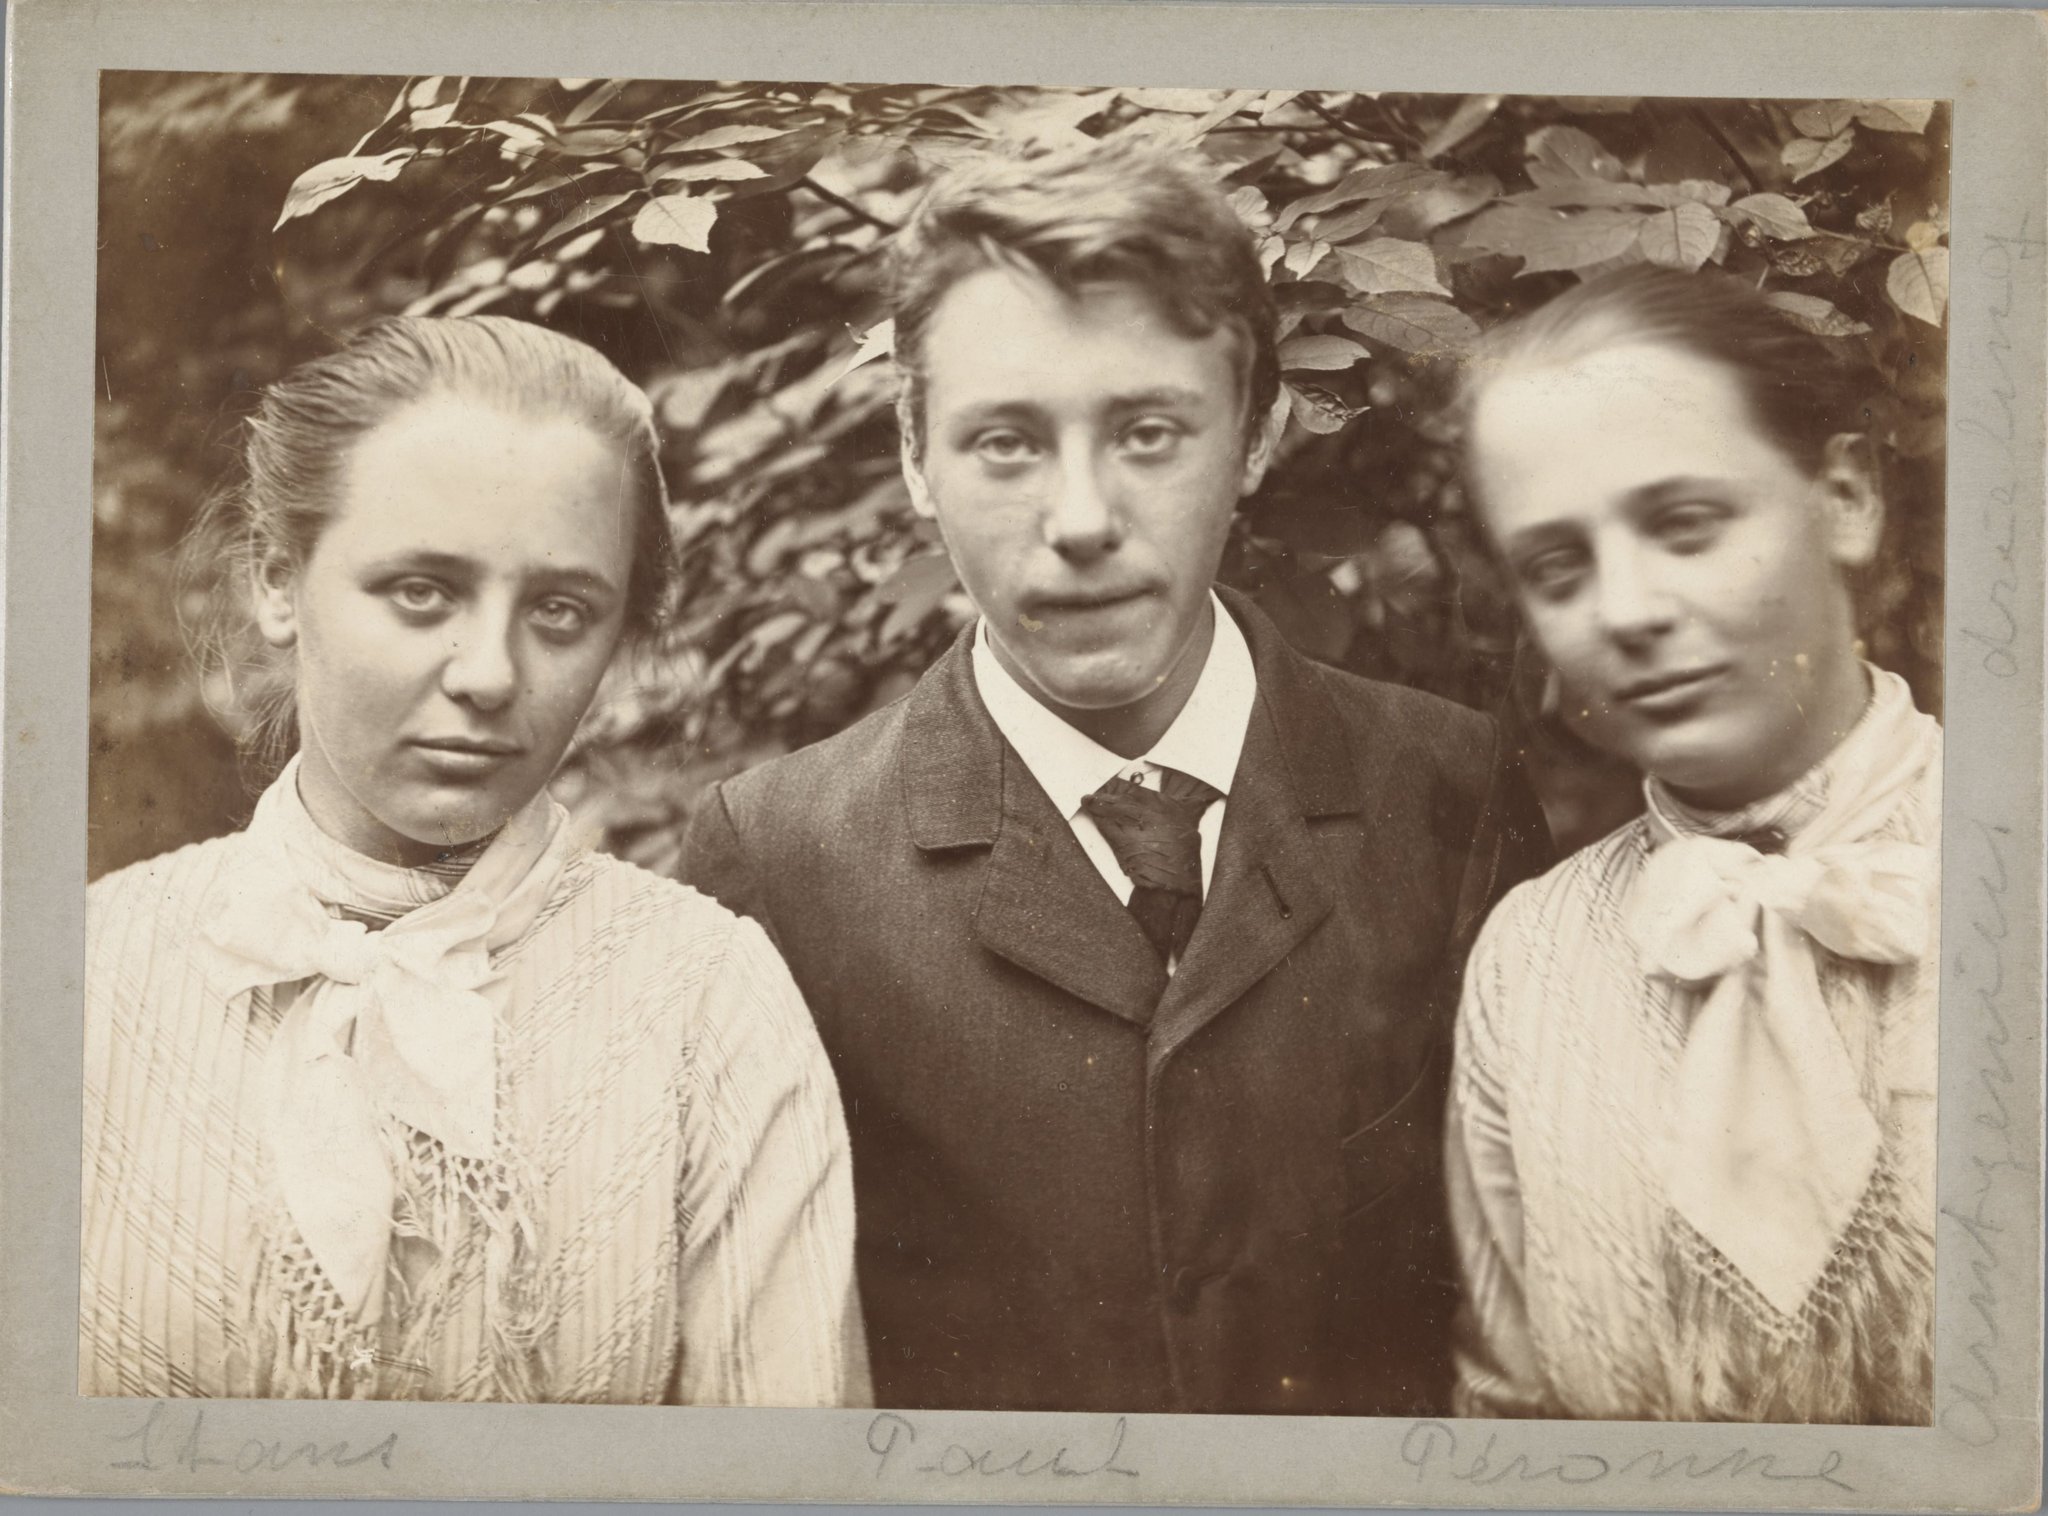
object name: photograph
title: The Triplets Stans, Paul, and Peronne Arntzenius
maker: willem witsen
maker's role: draughtsman, painter, print maker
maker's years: 1860-1923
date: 1860-1915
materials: cardboard, paper, photographic support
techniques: gelatin silver print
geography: amsterdam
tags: péronne arntzenius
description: The realism and directness of photography fascinated the artist Willem Witsen. He experimented with portraits in which the head was taken at close range and filled the frame. The close-up was his point of departure. During a visit to his brother-in-law Arntzenius he took various photographs of the latter’s children out of doors.